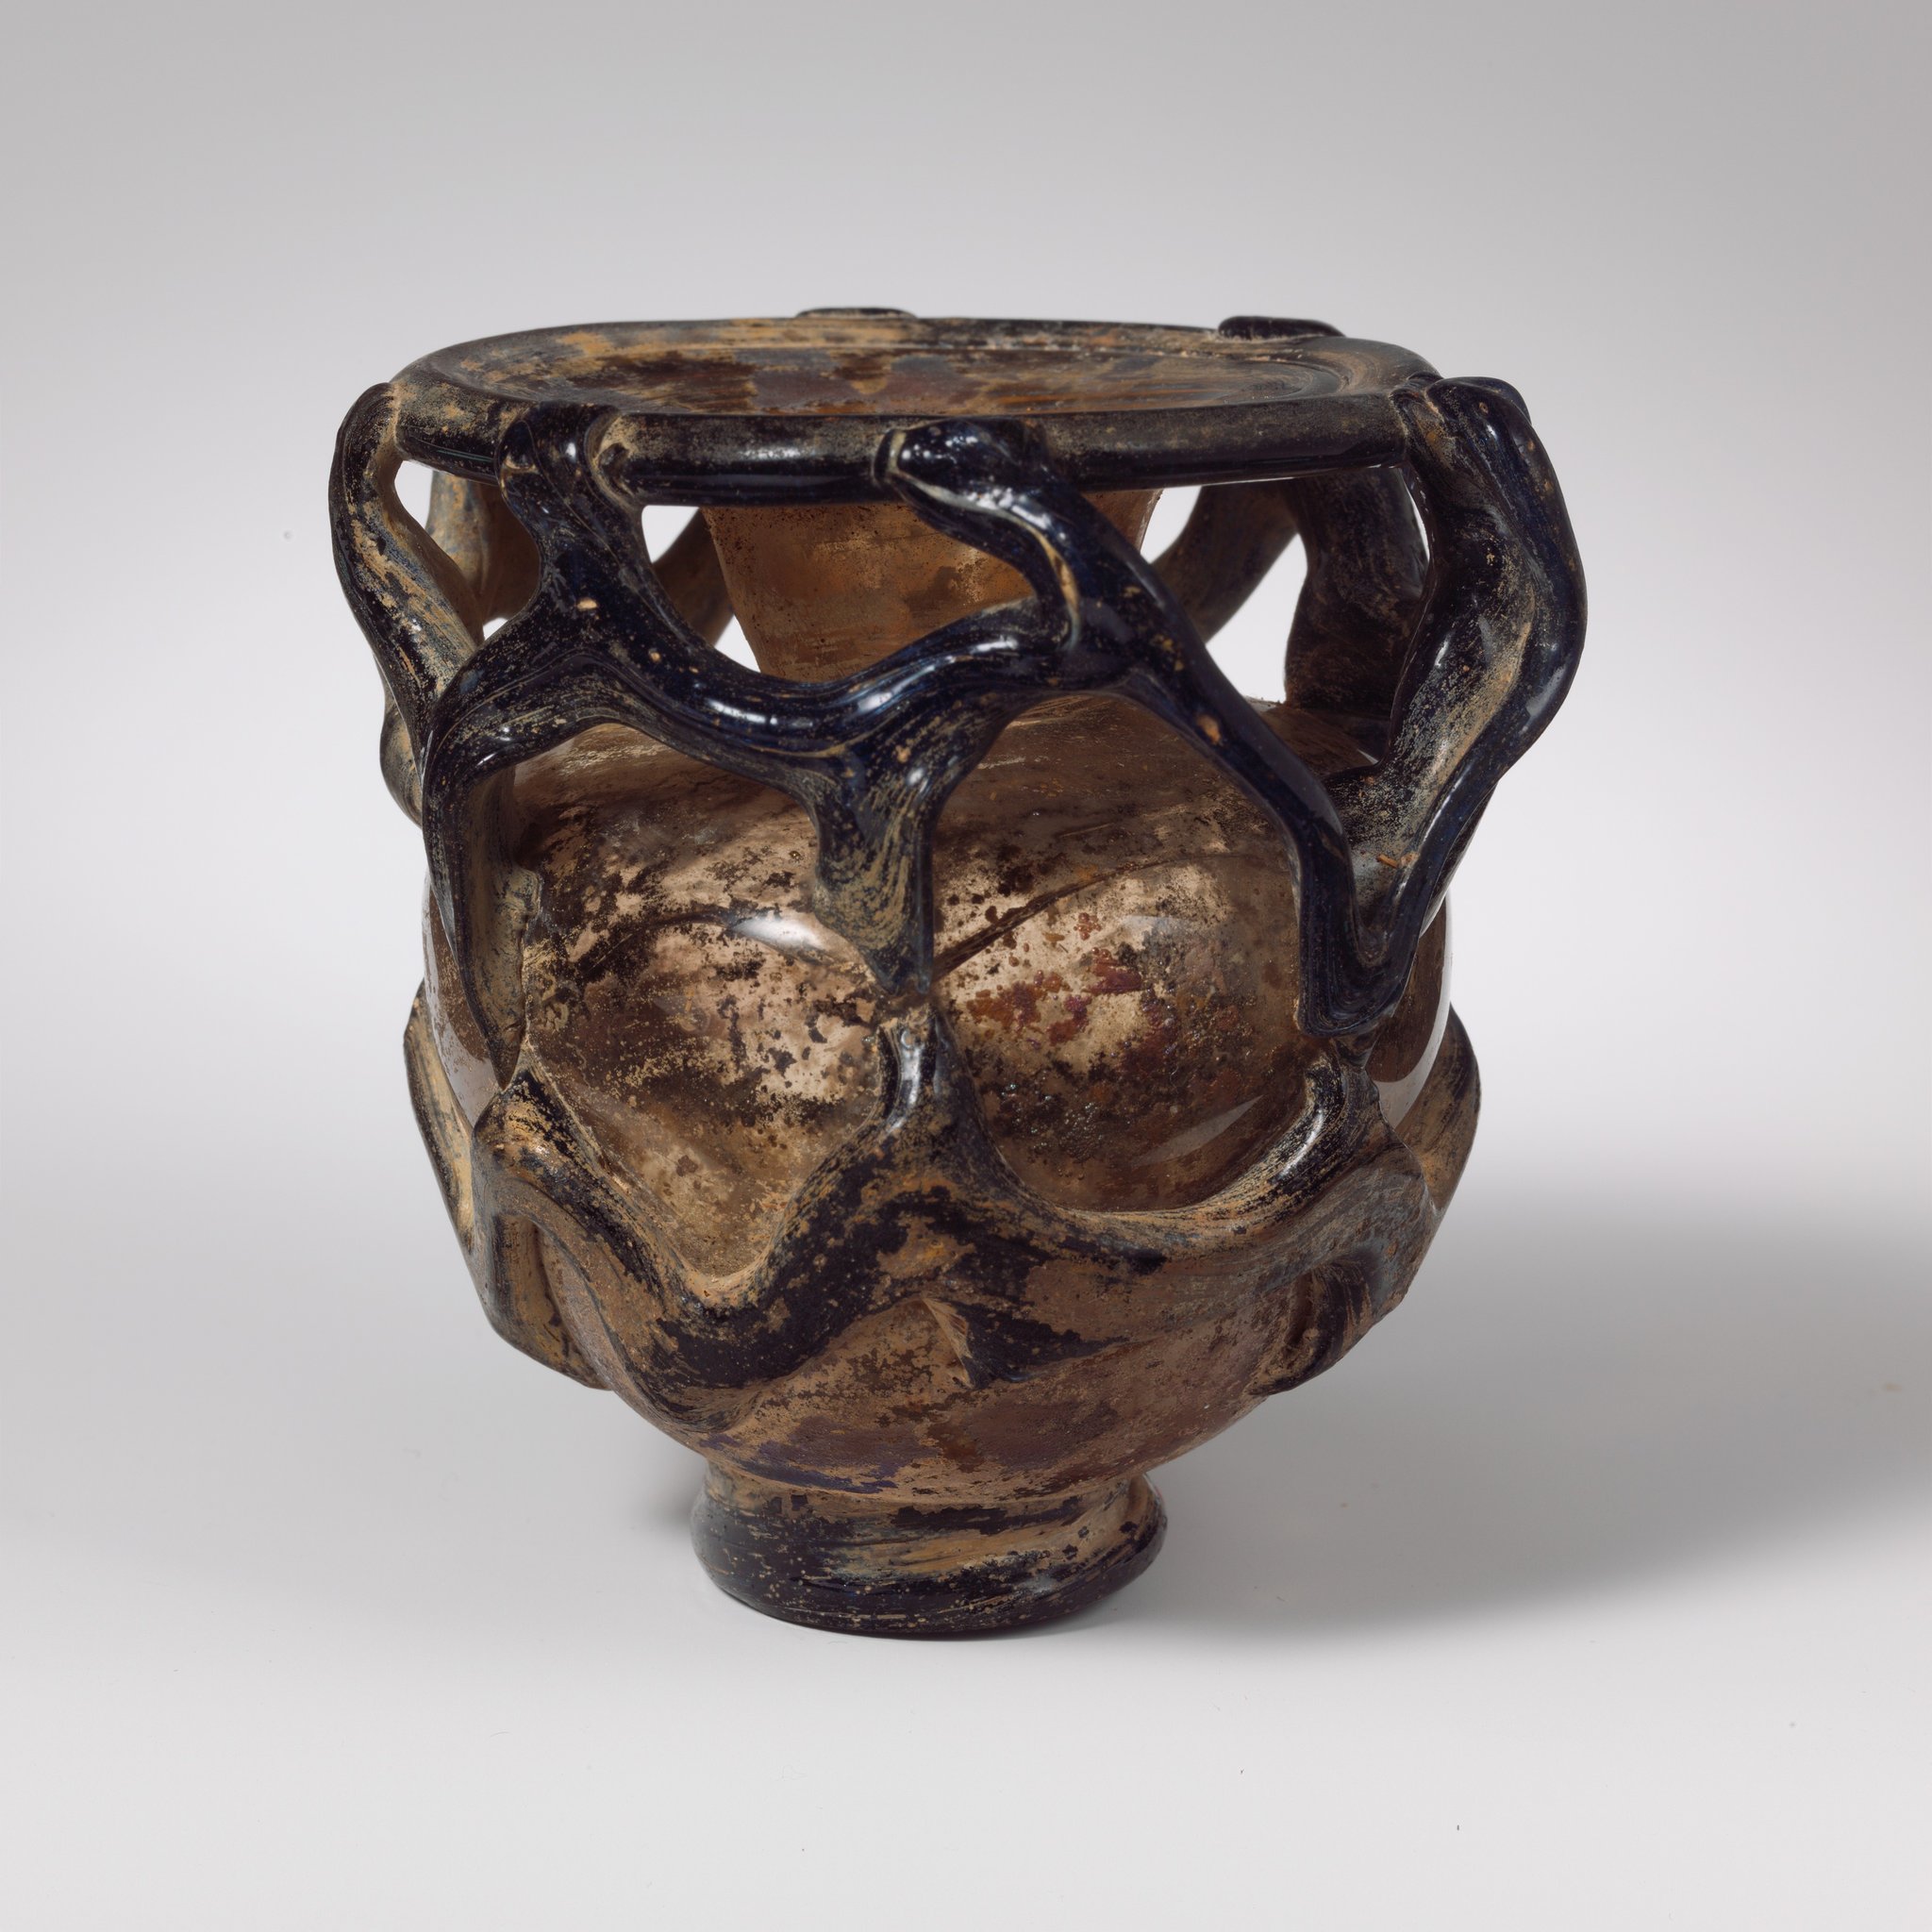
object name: jar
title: Glass jar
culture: roman, syrian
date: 301-500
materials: glass